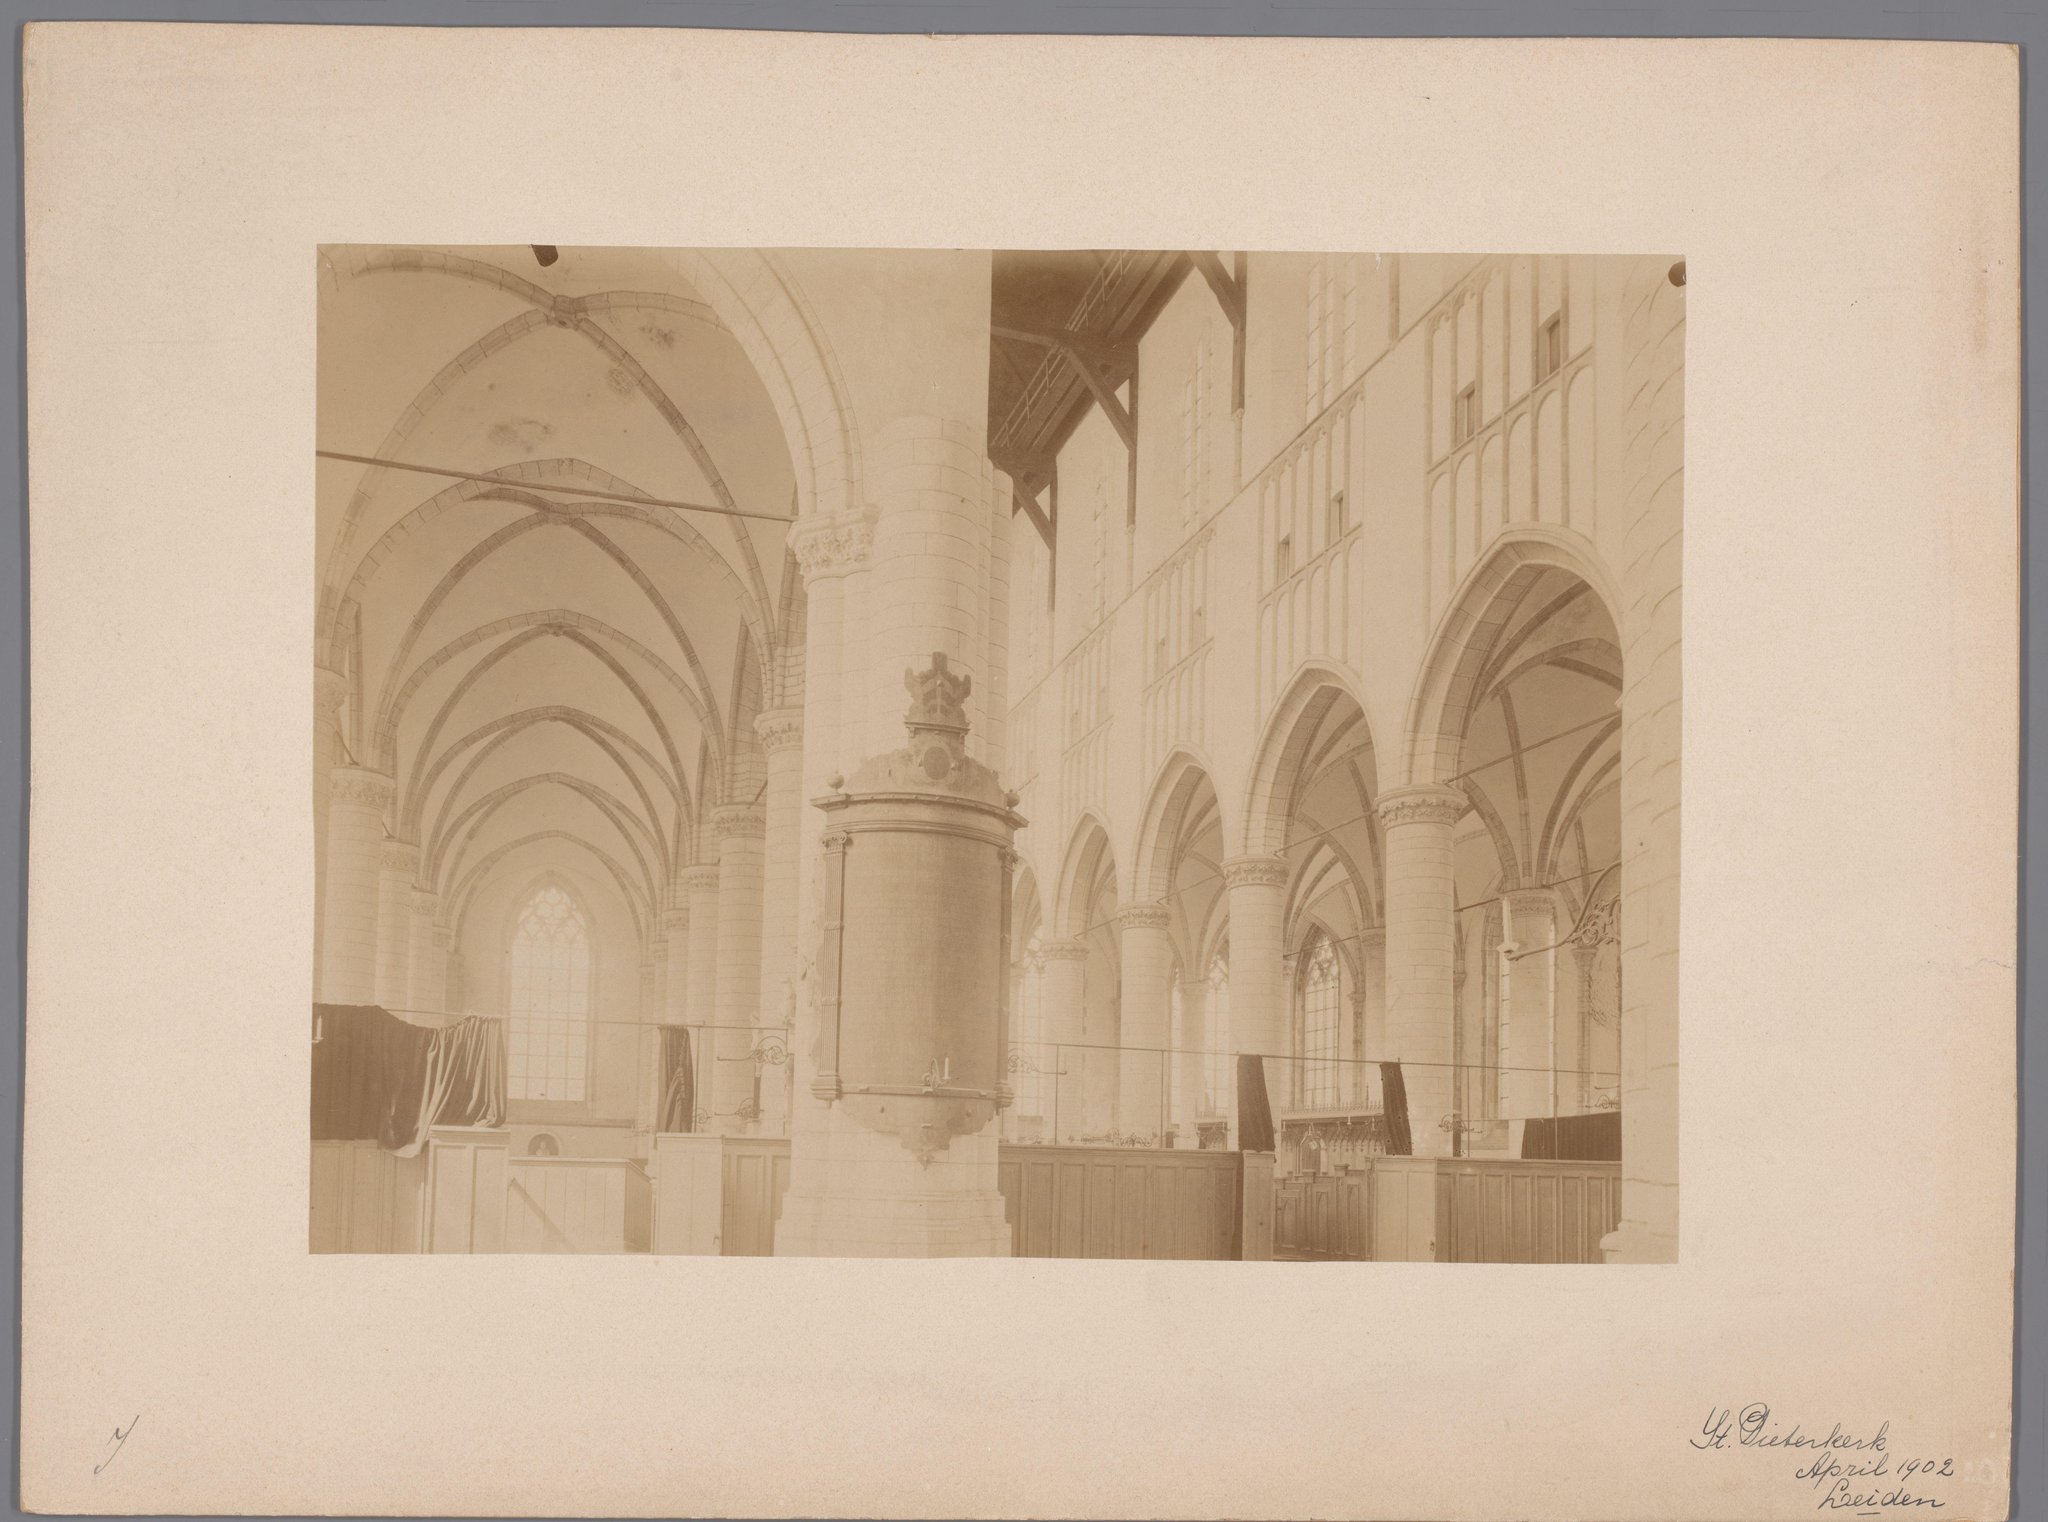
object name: photograph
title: Interieur van de Pieterskerk te Leiden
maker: anoniem (monumentenzorg)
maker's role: fotograaf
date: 1902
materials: cardboard, photographic support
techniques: albumen print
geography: leiden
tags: interior of church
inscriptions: annotation: ‘St. Pieterkerk/ April 1902/ Leiden’, annotation: ‘Leiden (Z.H.)/ st Pieterskerk/ april 1902’